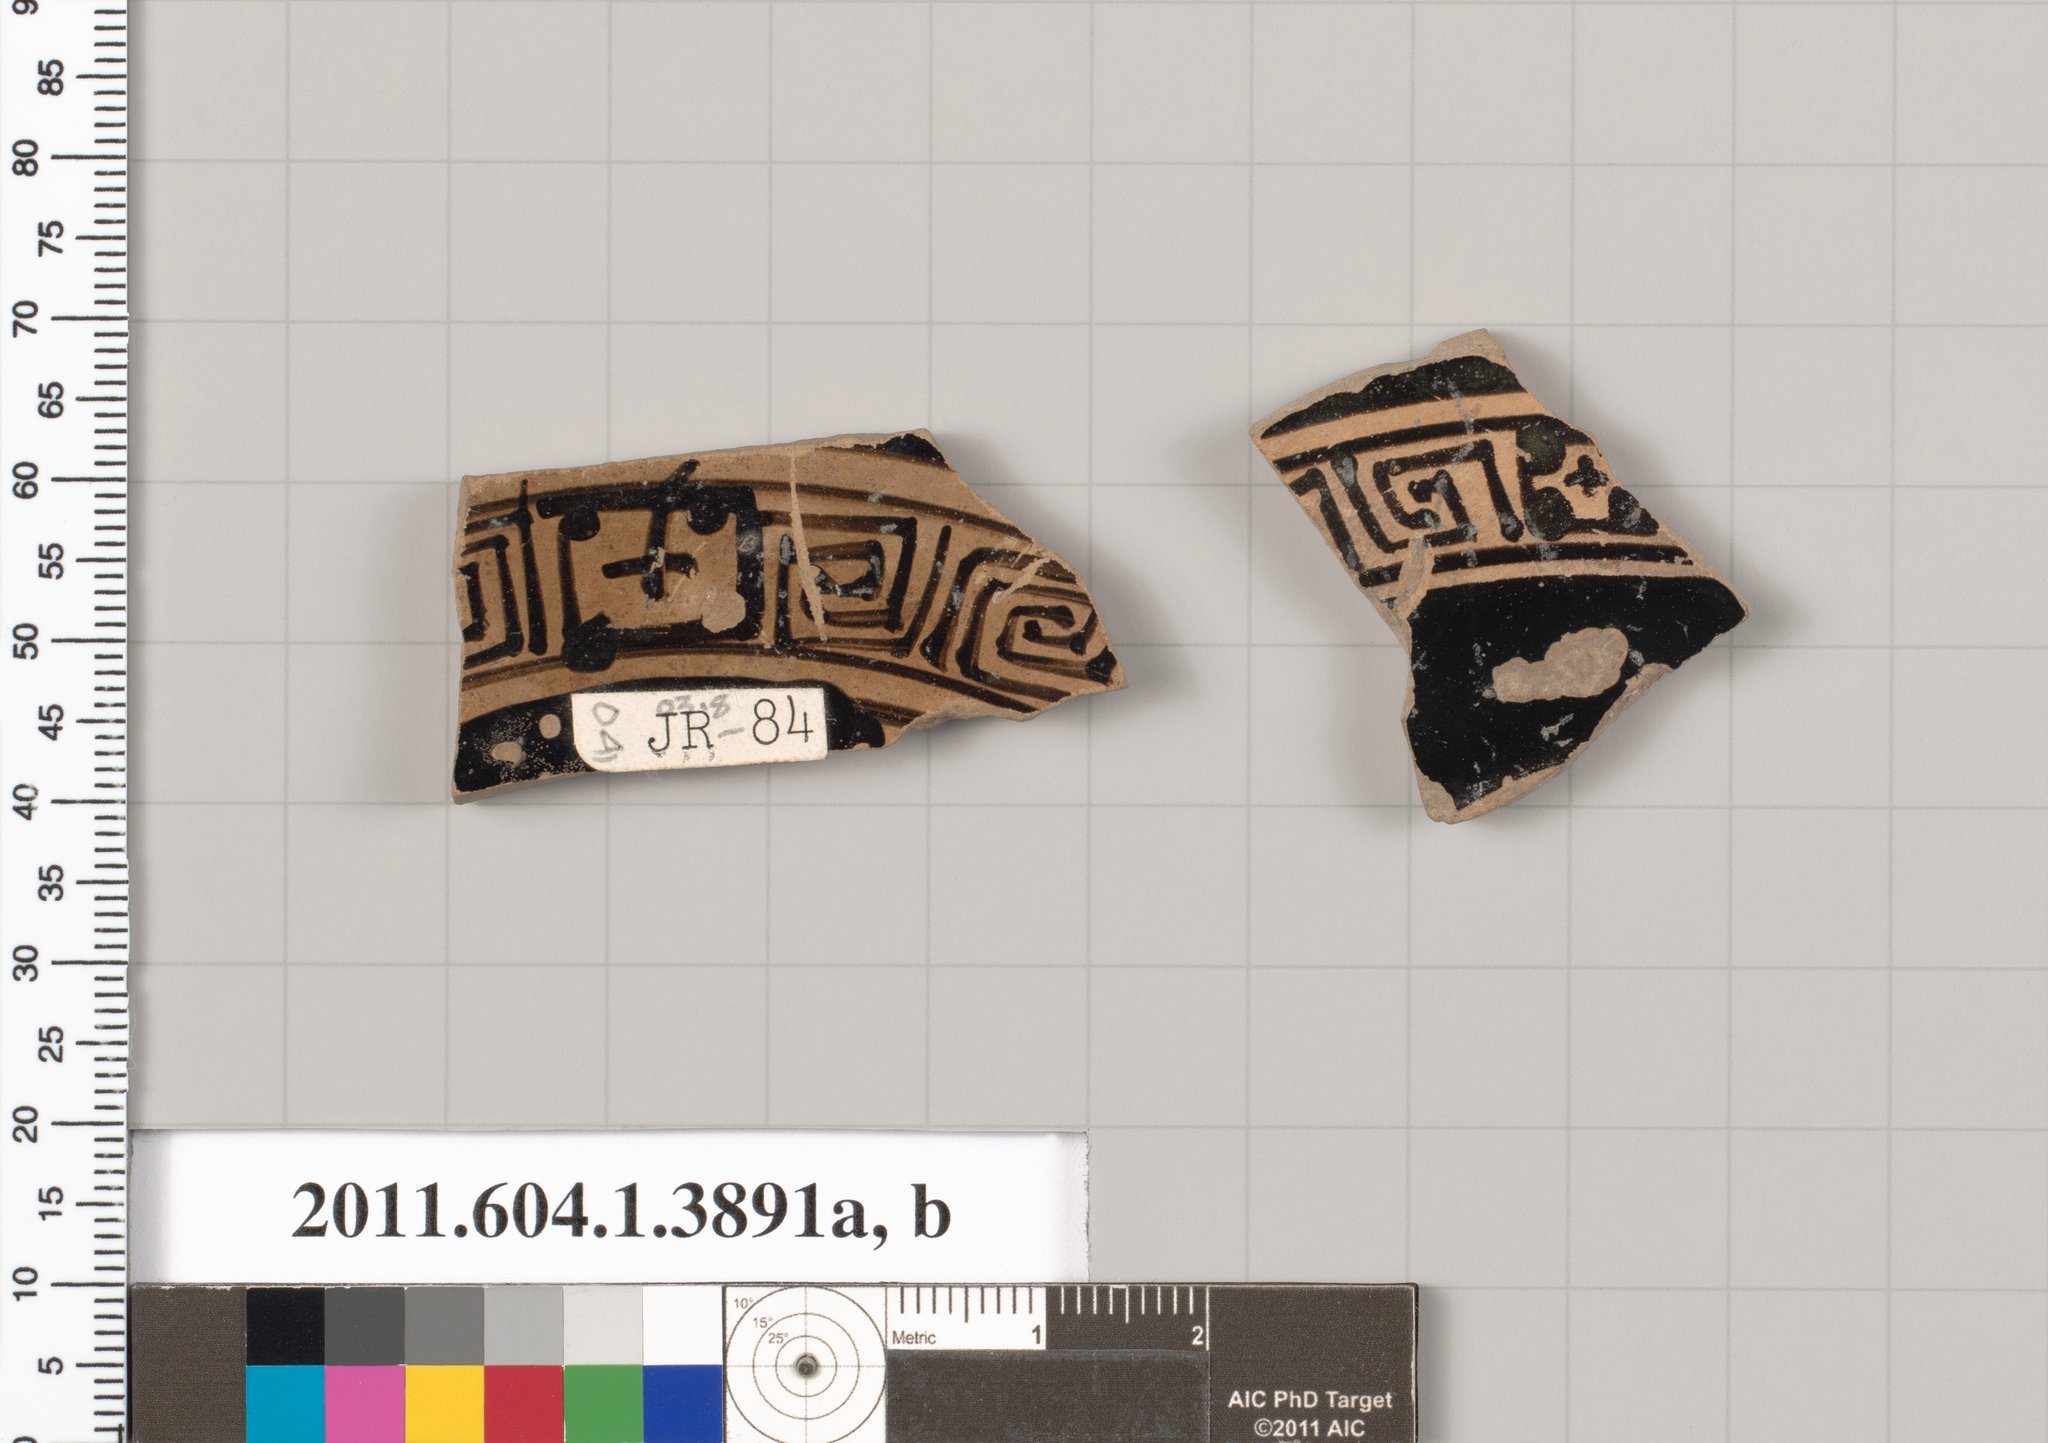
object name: kylix fragment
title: Terracotta fragments of kylikes (drinking cups)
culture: greek, attic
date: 475-451 BCE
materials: terracotta